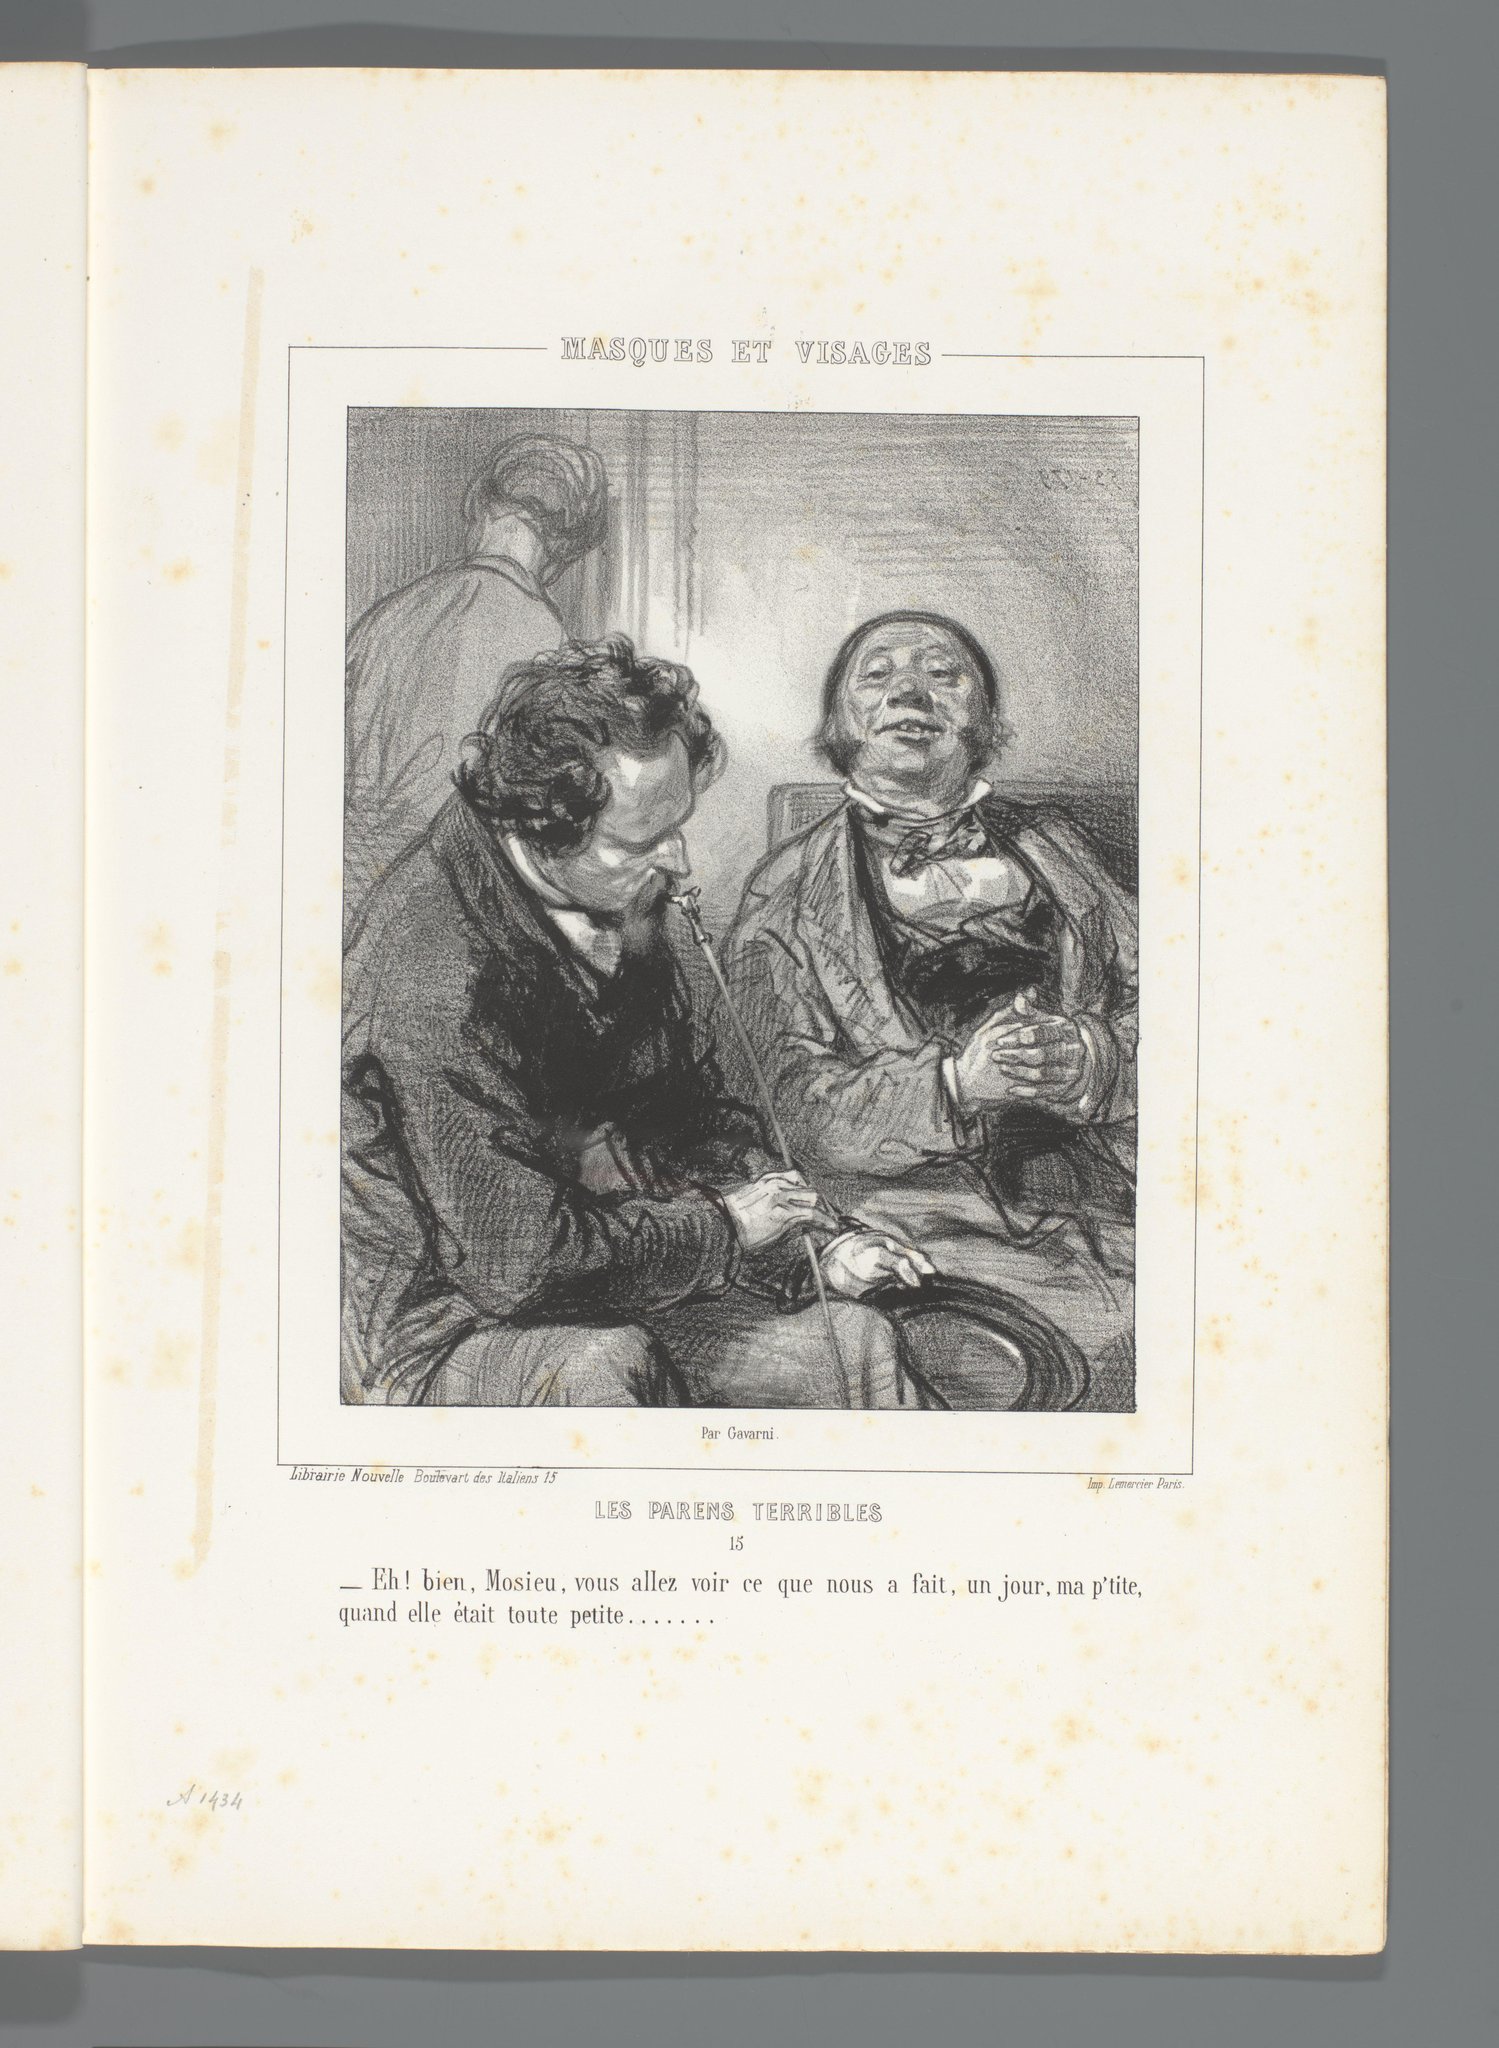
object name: album leaf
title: Masques et visages. Les parents terribles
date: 1853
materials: paper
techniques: lithograph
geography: paris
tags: parents with their children, old man, conversation, dialogue; conversation piece, father and daughter(s) (family group) (with number of daughters)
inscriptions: collector's mark: Lugt 2228a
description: Prent gebruikt voor: Paris (Journal), 22 november 1853.